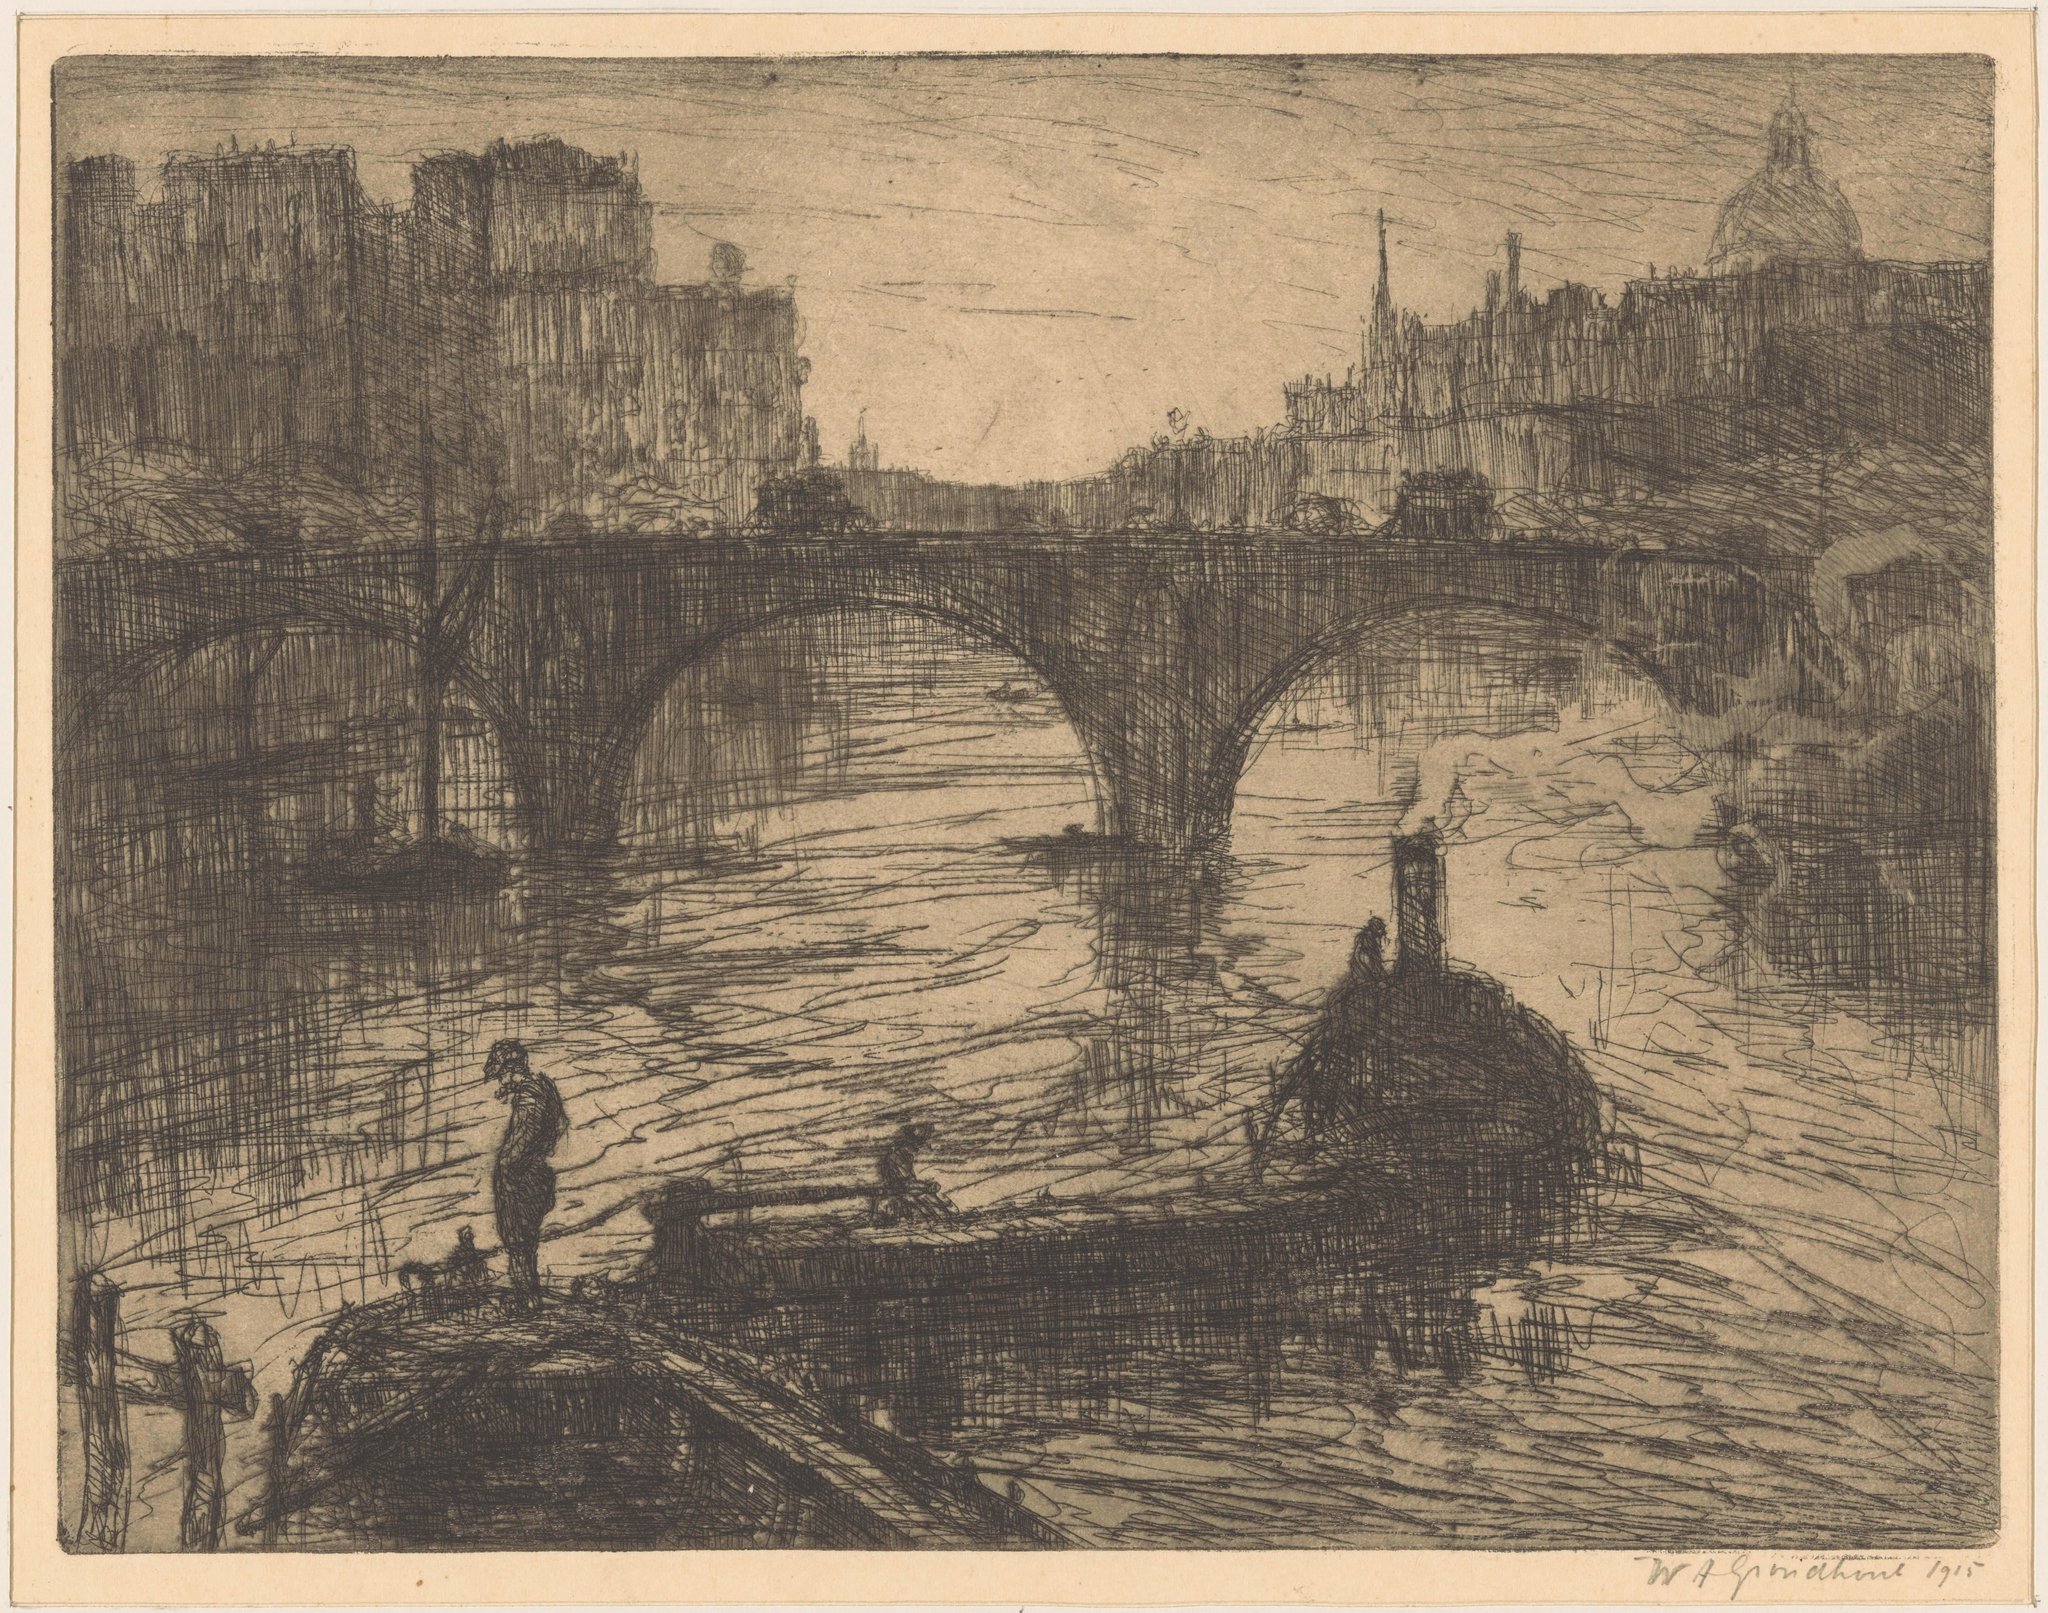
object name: print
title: Brug over de Theems in Londen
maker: willem adrianus grondhout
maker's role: draughtsman, painter, print maker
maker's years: 1878-1934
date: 1915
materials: paper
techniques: etching, intaglio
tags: ships (in general), bridge in city across river, canal, etc., london, thames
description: Op de voorgrond schuiten. Rechts op de achtergrond de koepel van een gebouw.